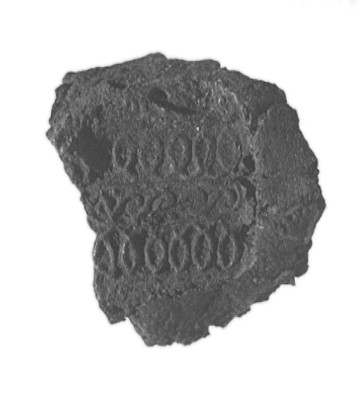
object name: sealing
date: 2030-1640 BCE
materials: clay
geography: egypt